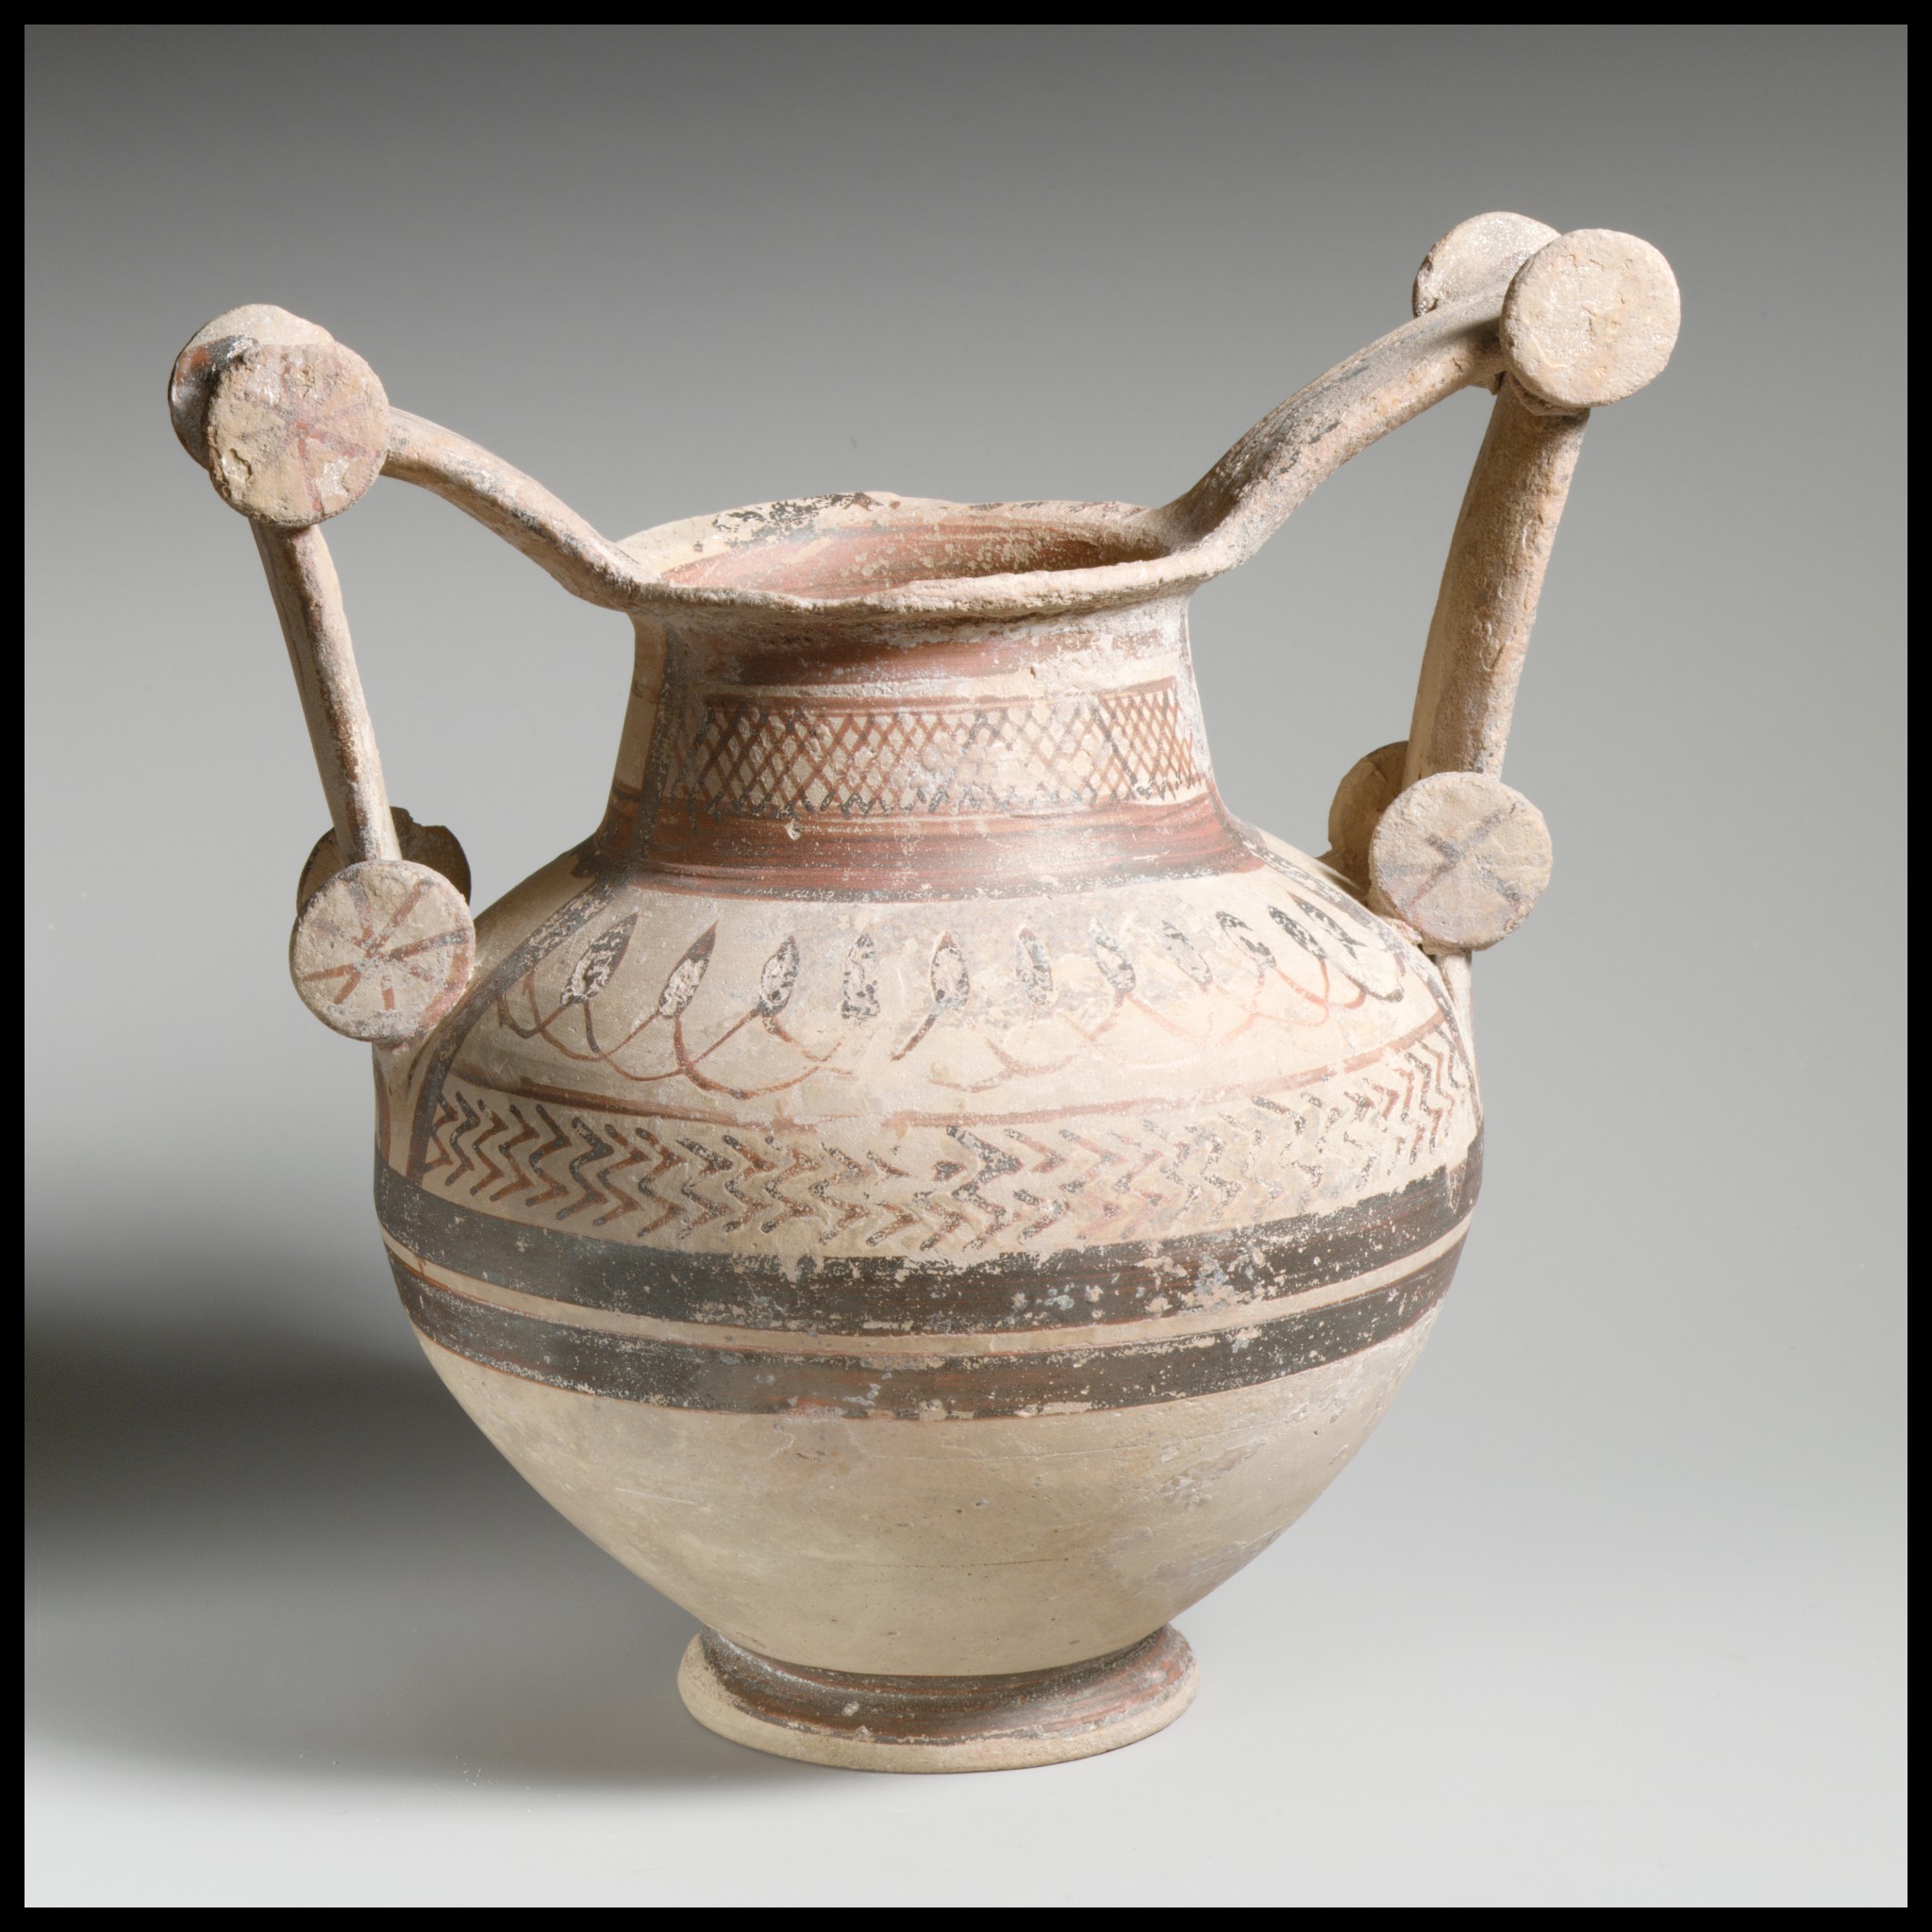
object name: trozella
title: Terracotta trozella (two-handled jar)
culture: apulian or italic-native or messapian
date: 434-368 BCE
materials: terracotta